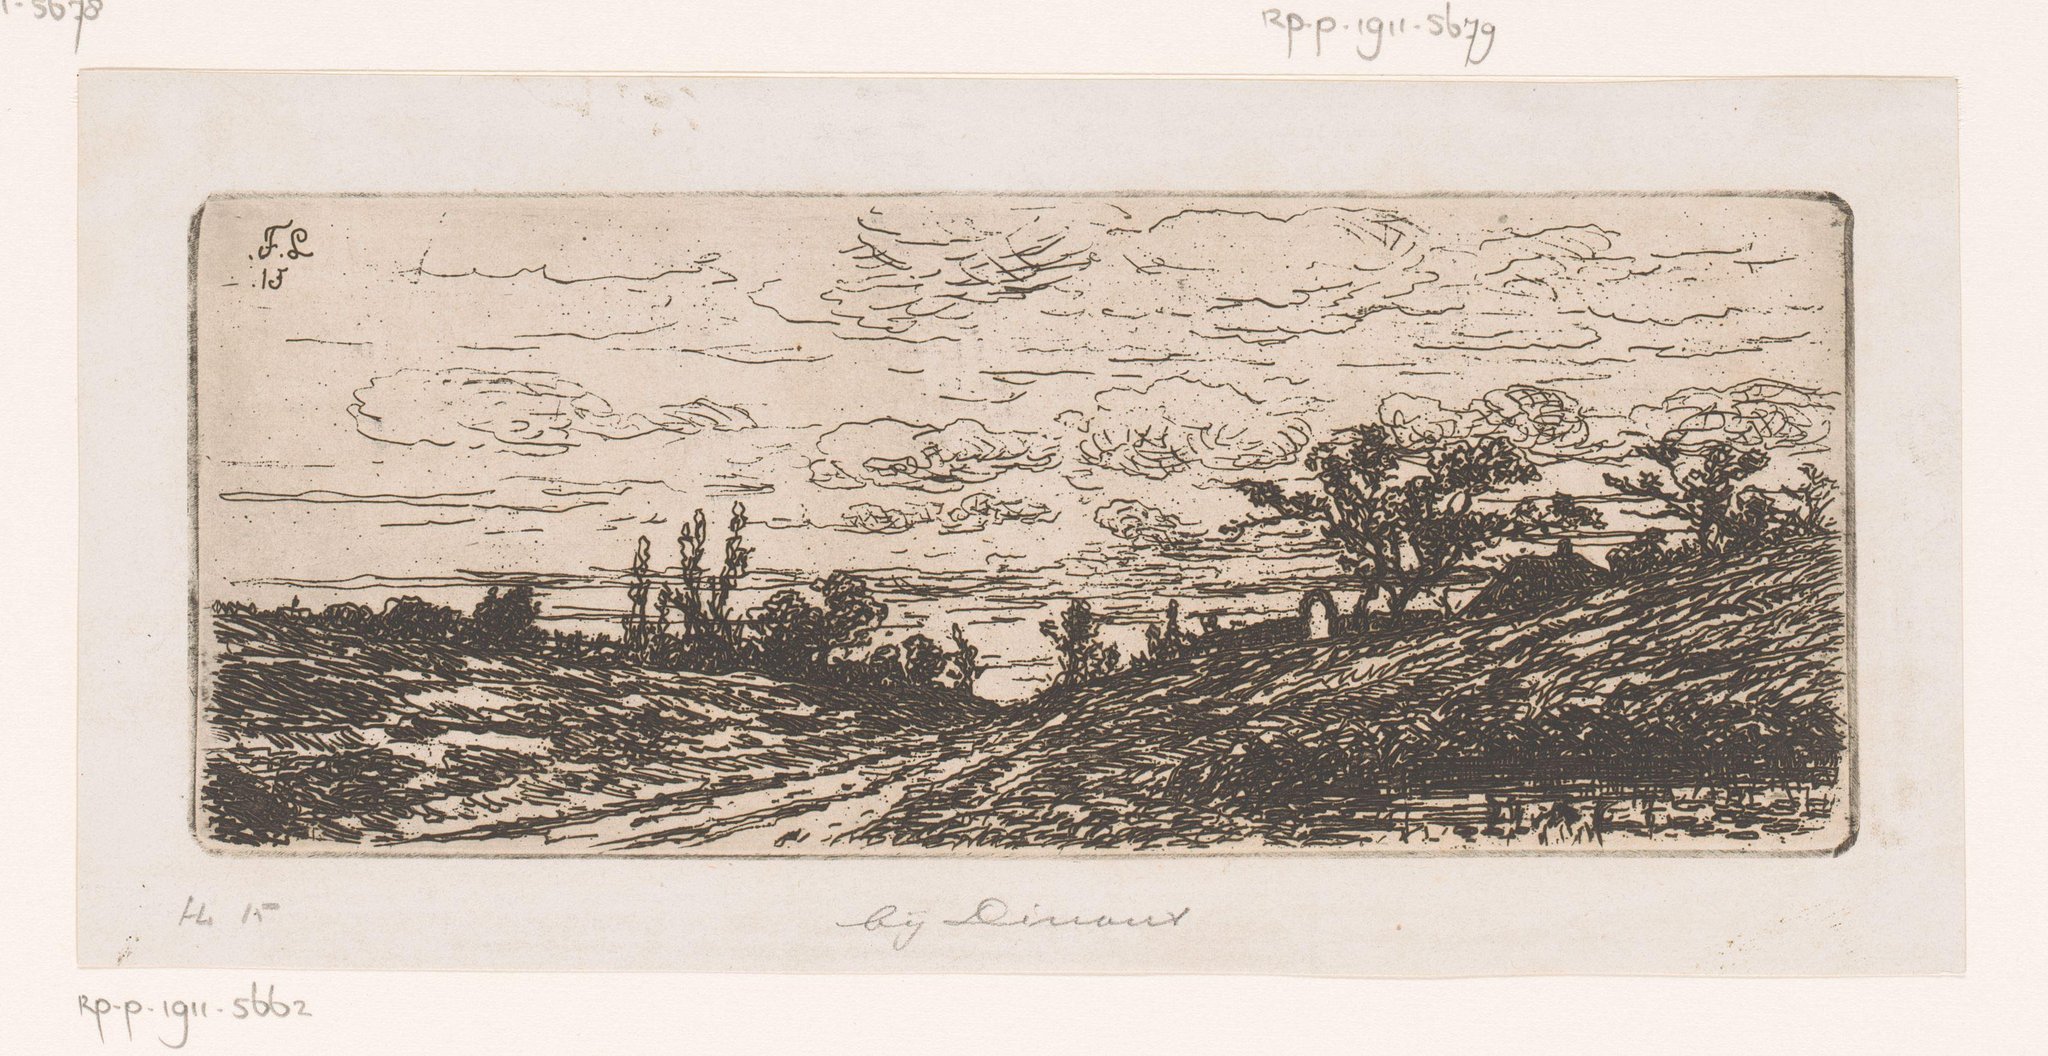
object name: print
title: Landschap bij Dinant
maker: jean pierre françois lamorinière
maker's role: print maker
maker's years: 1828-1911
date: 1838-1911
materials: paper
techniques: etching, intaglio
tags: landscapes in the temperate zone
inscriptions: collector's mark: Lugt 1485, collector's mark: Lugt 2228